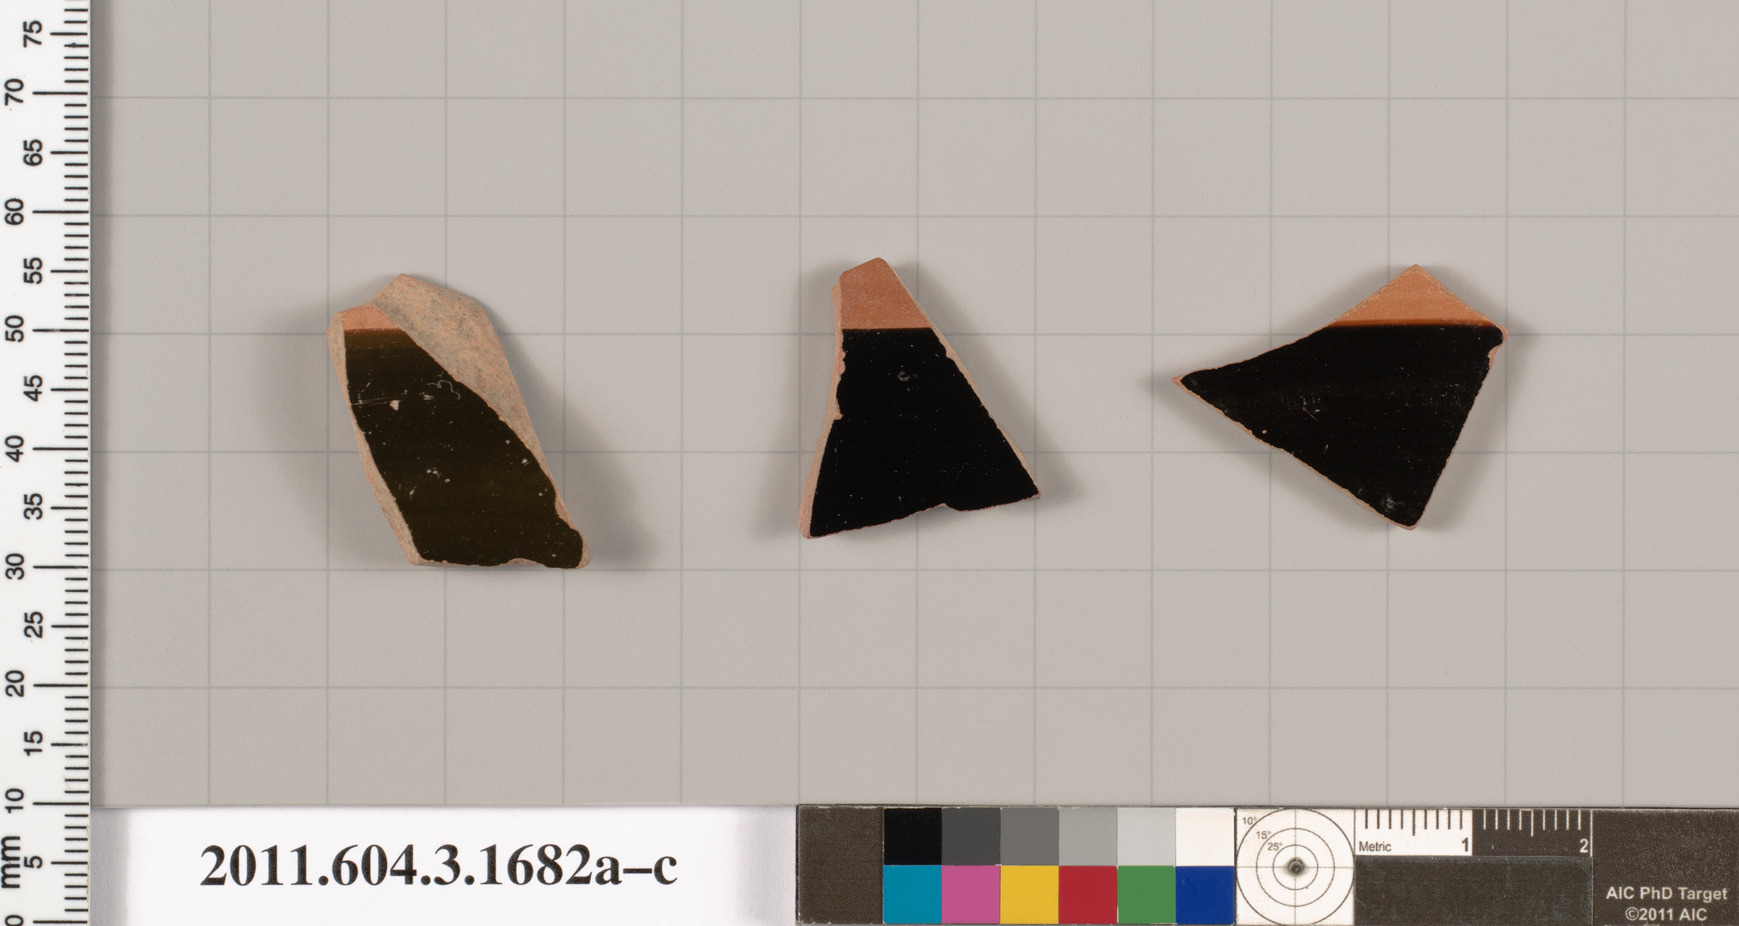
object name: kylix fragment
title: Terracotta fragments of kylikes: Band or lip cups (drinking cups)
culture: greek, attic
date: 550-526 BCE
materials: terracotta